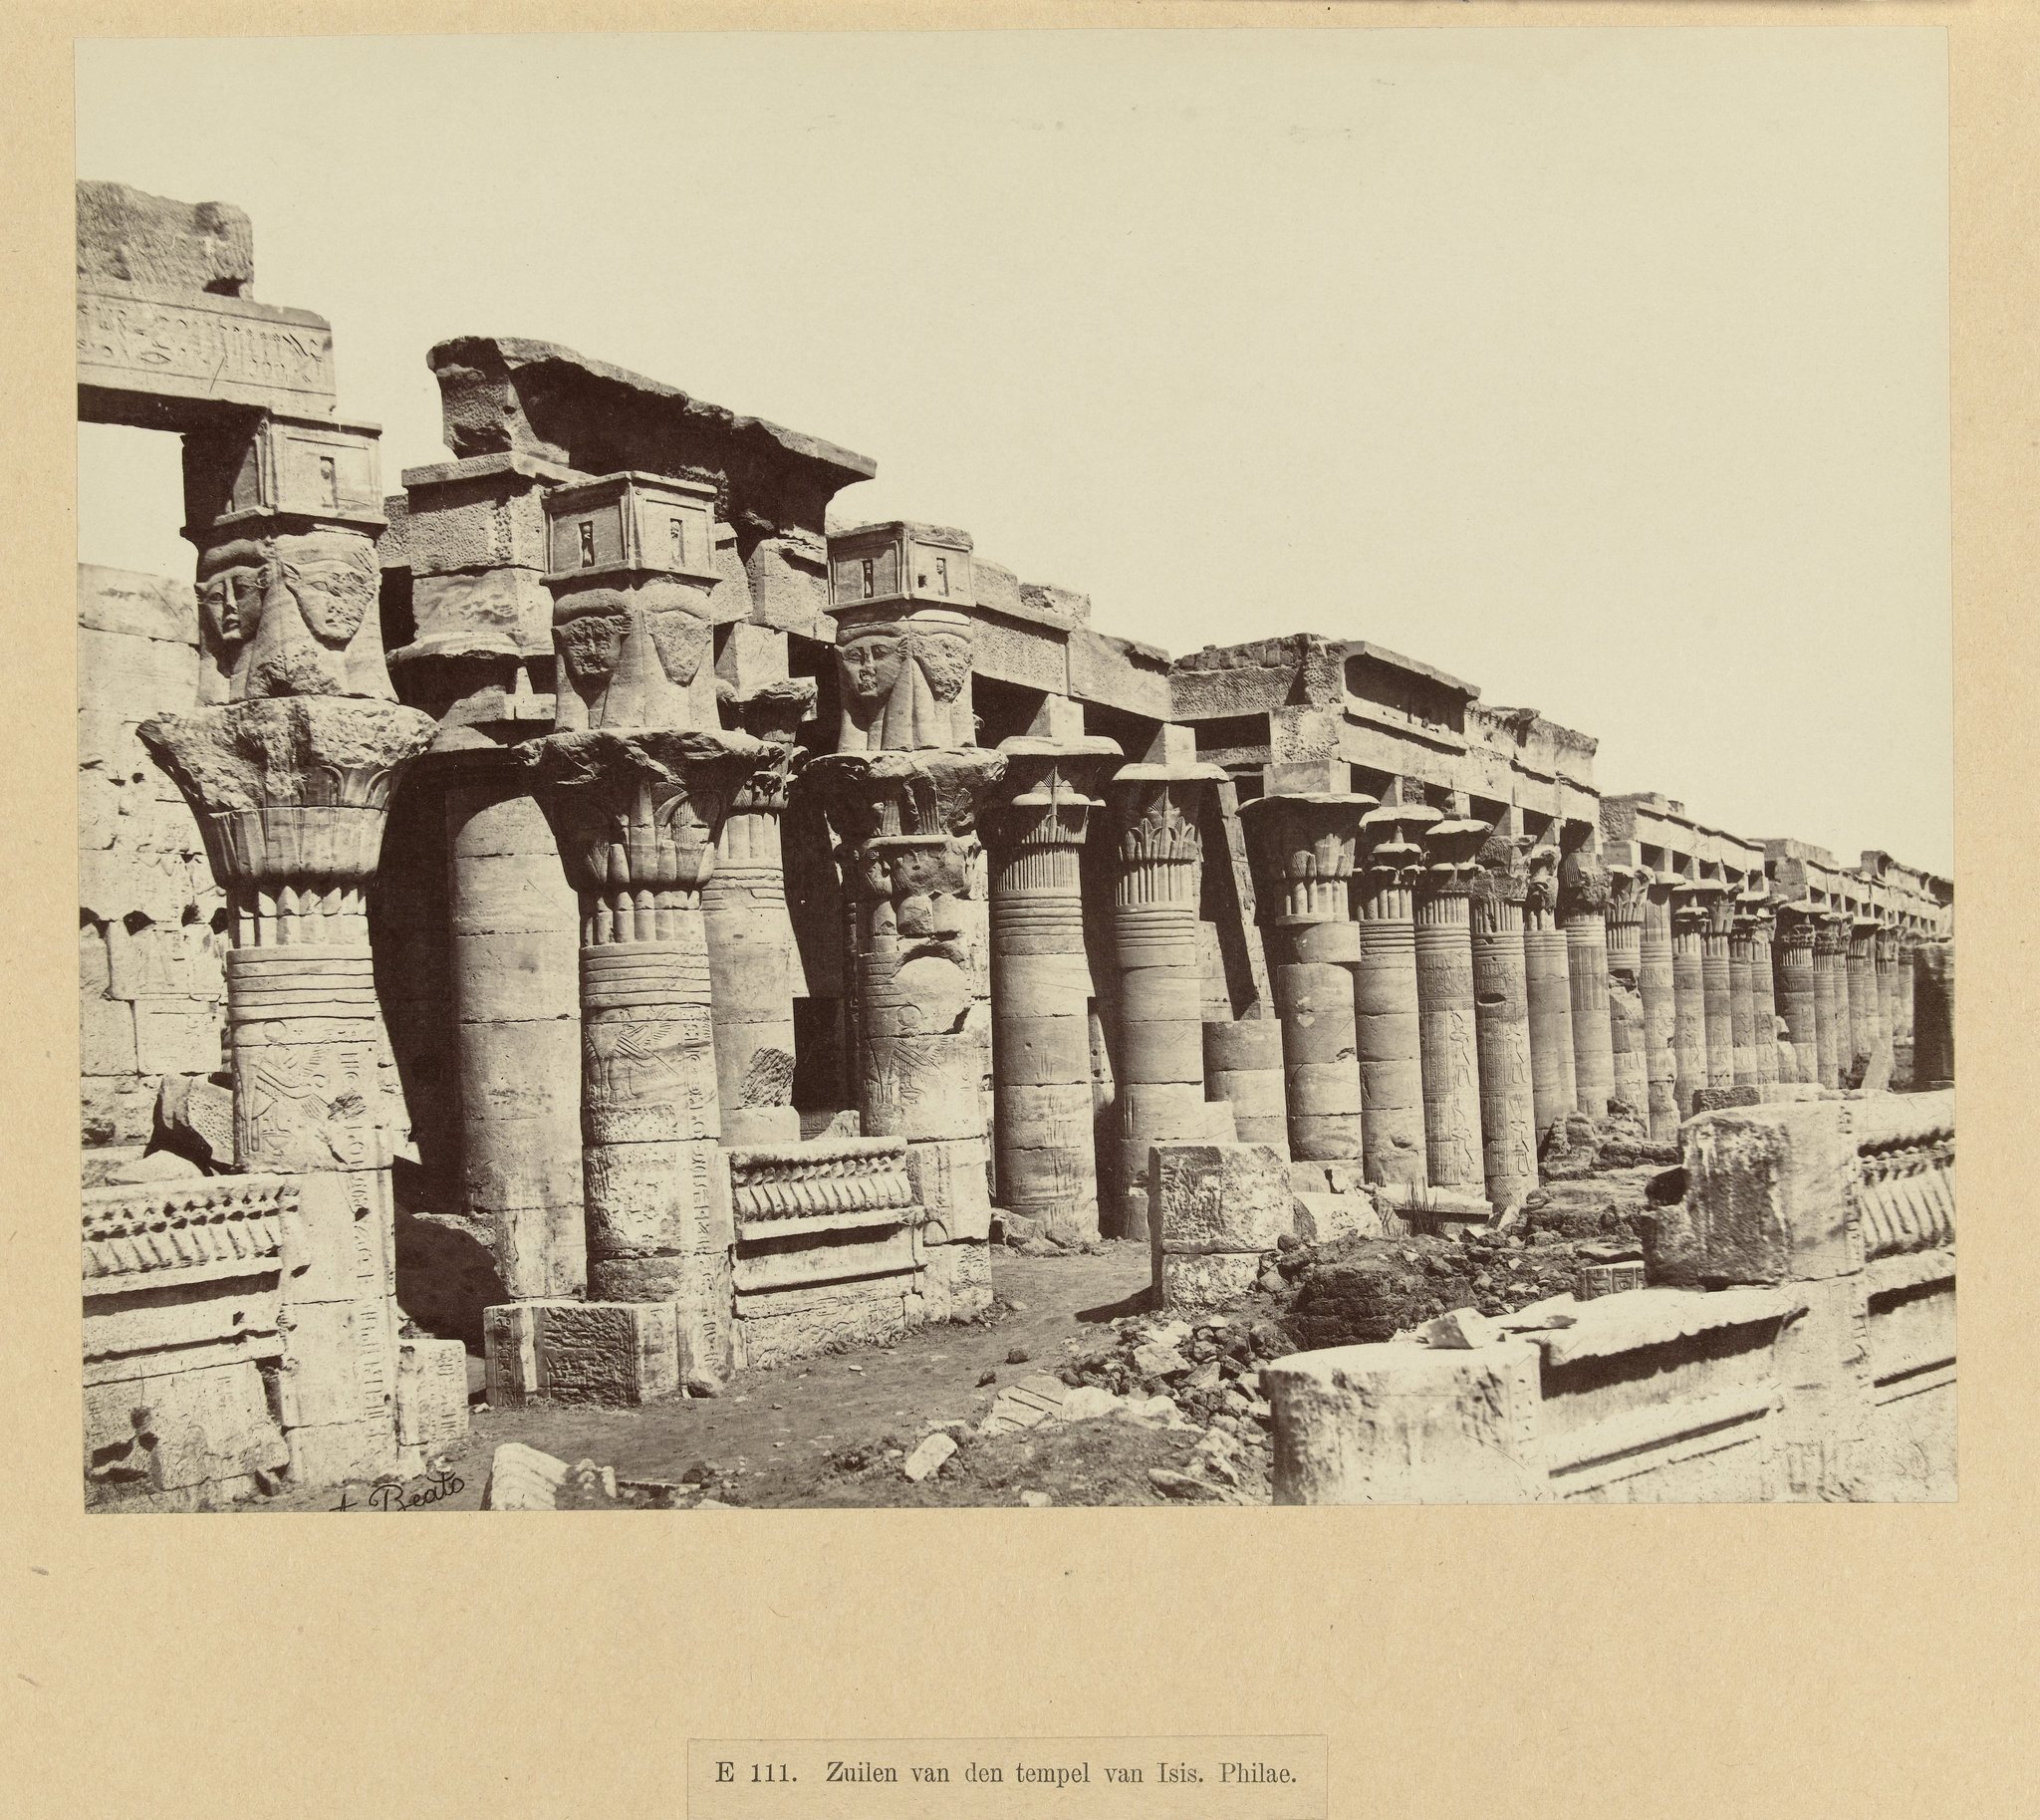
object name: photograph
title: Zuilengalerij van de tempel van Isis op het eiland Philae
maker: antonio beato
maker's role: fotograaf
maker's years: 1835-1906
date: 1862-1895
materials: cardboard, paper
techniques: albumen print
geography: philae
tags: temple, shrine ~ egyptian religion, column, pillar ~ architecture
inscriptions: stamp: ‘Gemeentelijke bibliotheek/ Rotterdam’, check stamp: ‘Bristol/ L.M.’, title: ‘E 111. Zuilen van den tempel van Isis, Philae.’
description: Onderdeel van een groep door fotograaf Richard Polak op reis verzamelde foto’s. Deze foto is samen met andere op zijn reizen verzamelde foto's tentoongesteld bij de Rotterdamsche Kunstkring (1895), Arti en Amicitiae te Amsterdam (1897-1898?) en Societeit 't Collegie te Kampen (datum vooralsnog onbekend).